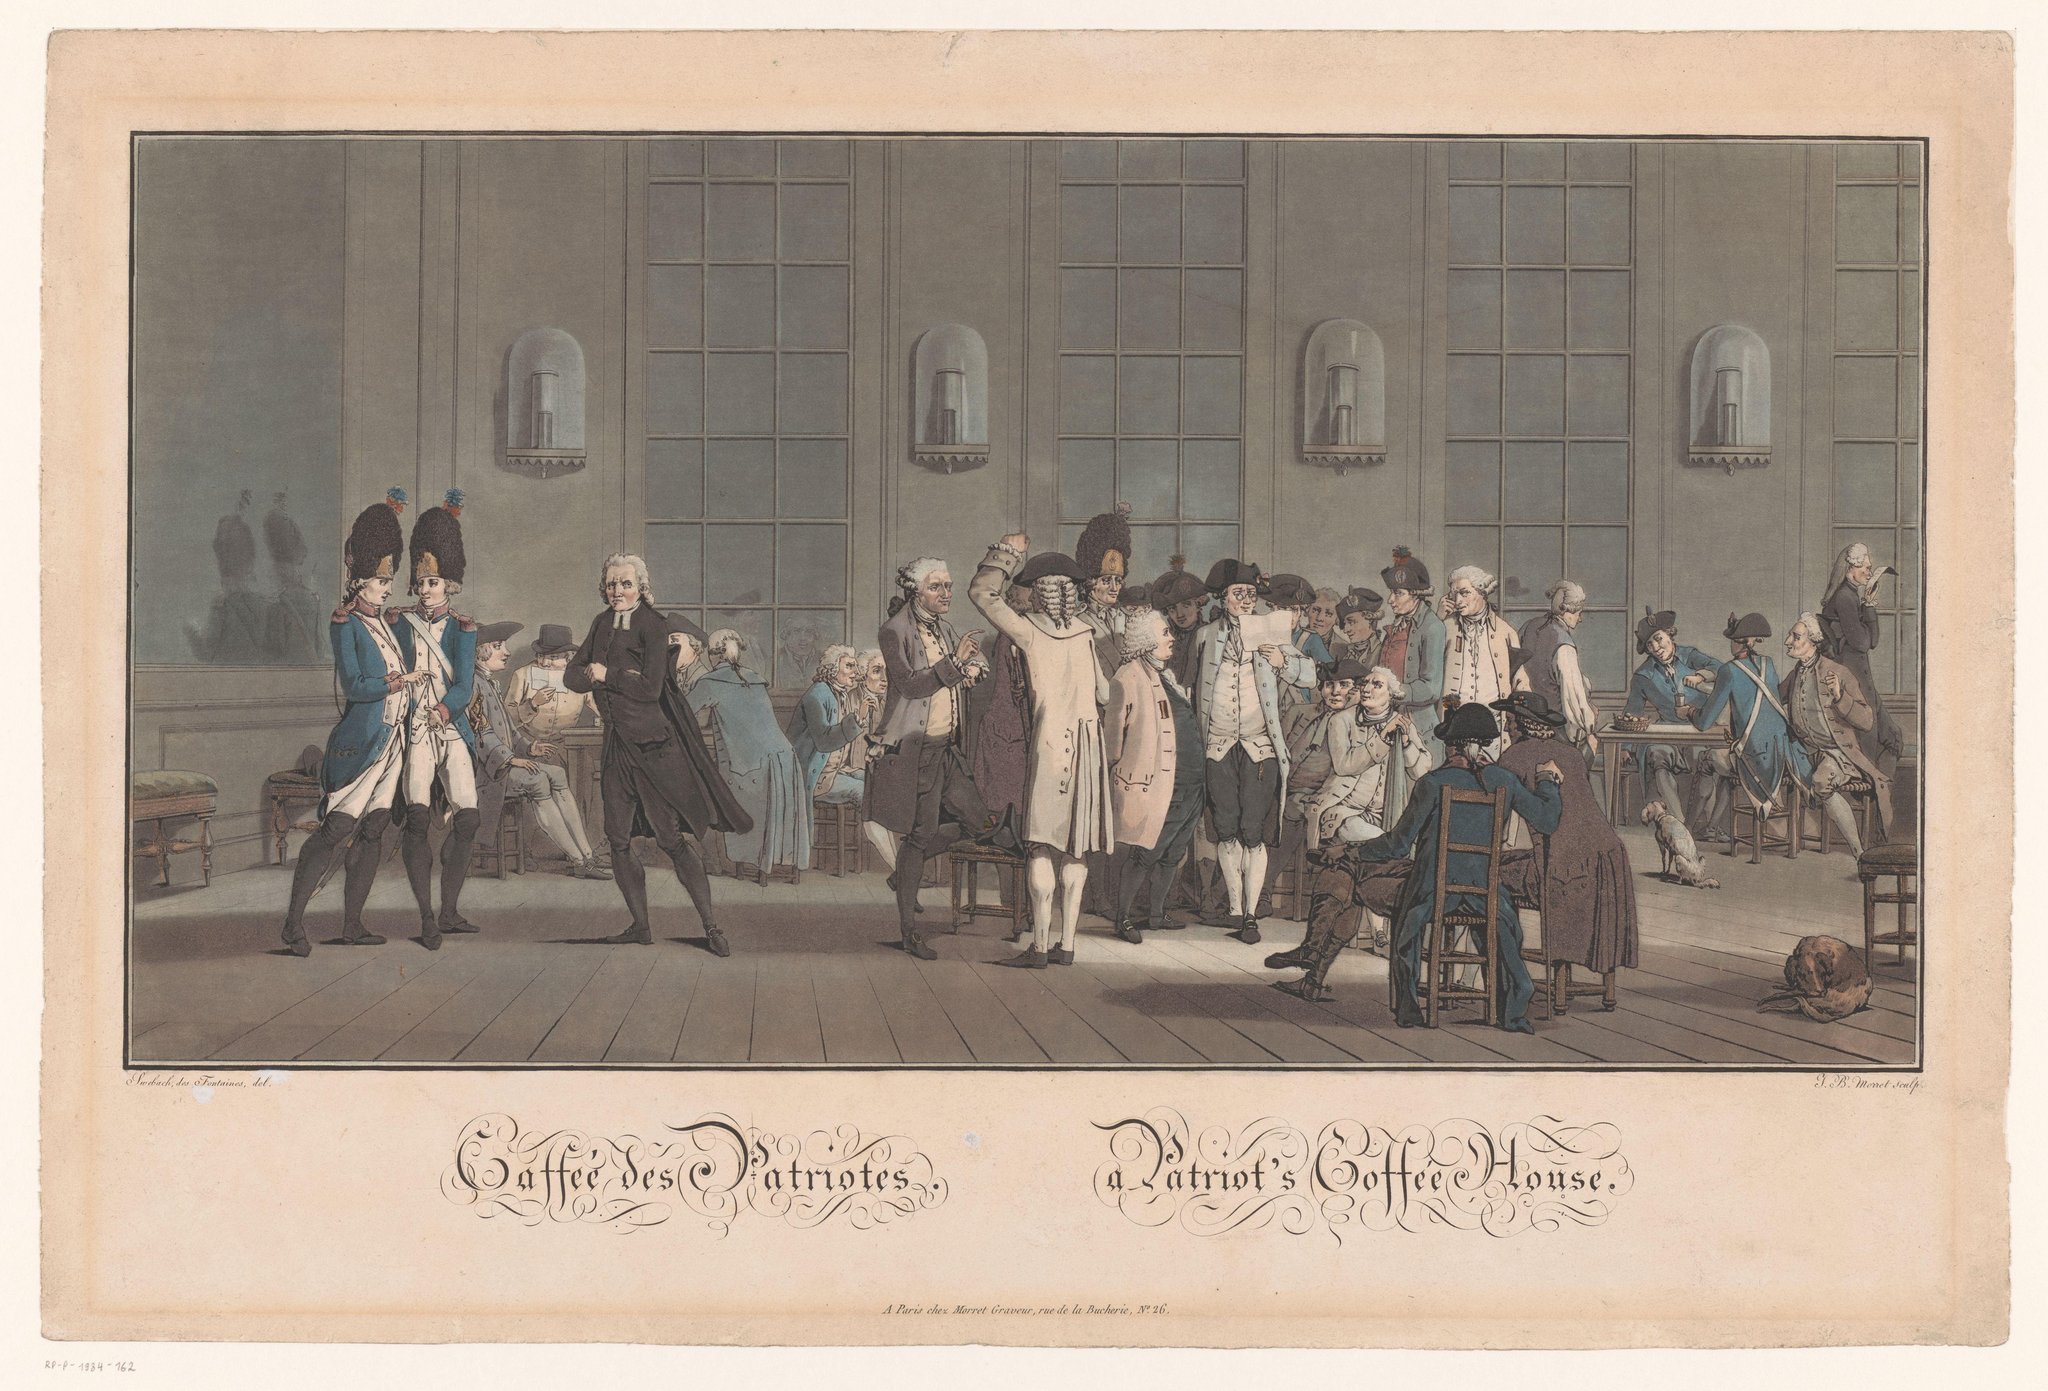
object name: print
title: Café met patriotten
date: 1785-1825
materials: paper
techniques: color aquatint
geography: paris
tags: inn, coffee-house, public house, etc., patriot (revolutionary)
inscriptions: collector's mark: Lugt 2760, collector's mark: Lugt 2228